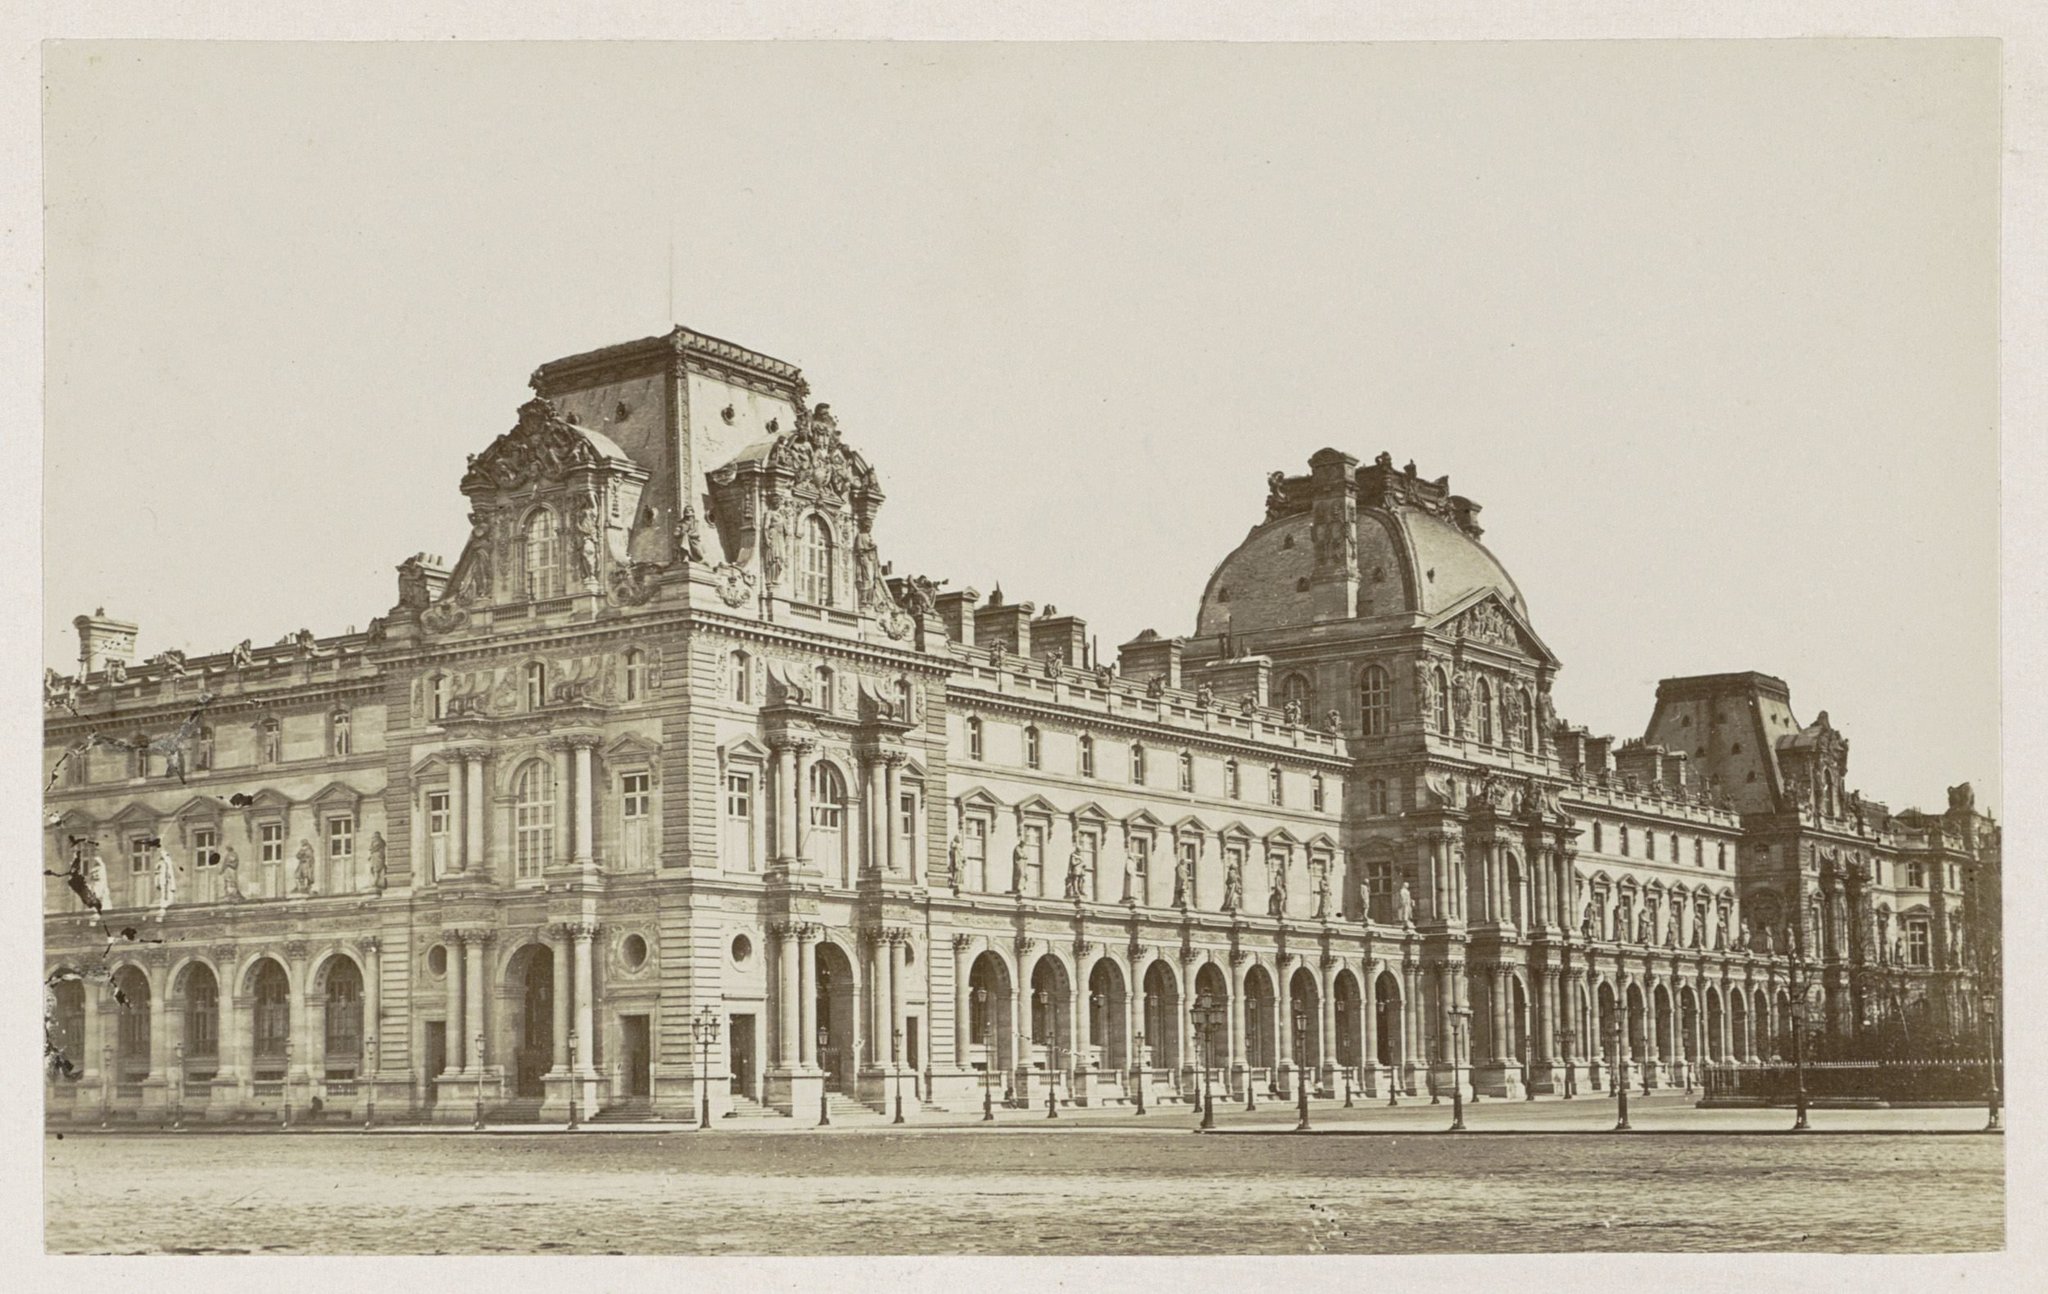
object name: photograph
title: Rechtervleugel van het Louvre in Parijs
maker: Anonymous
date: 1878-1890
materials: photographic support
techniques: albumen print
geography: paris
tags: permanent exhibition, museum, façade (of house or building), paris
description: Onderdeel van Reisalbum Europese steden, vermoedelijk Zweeds.